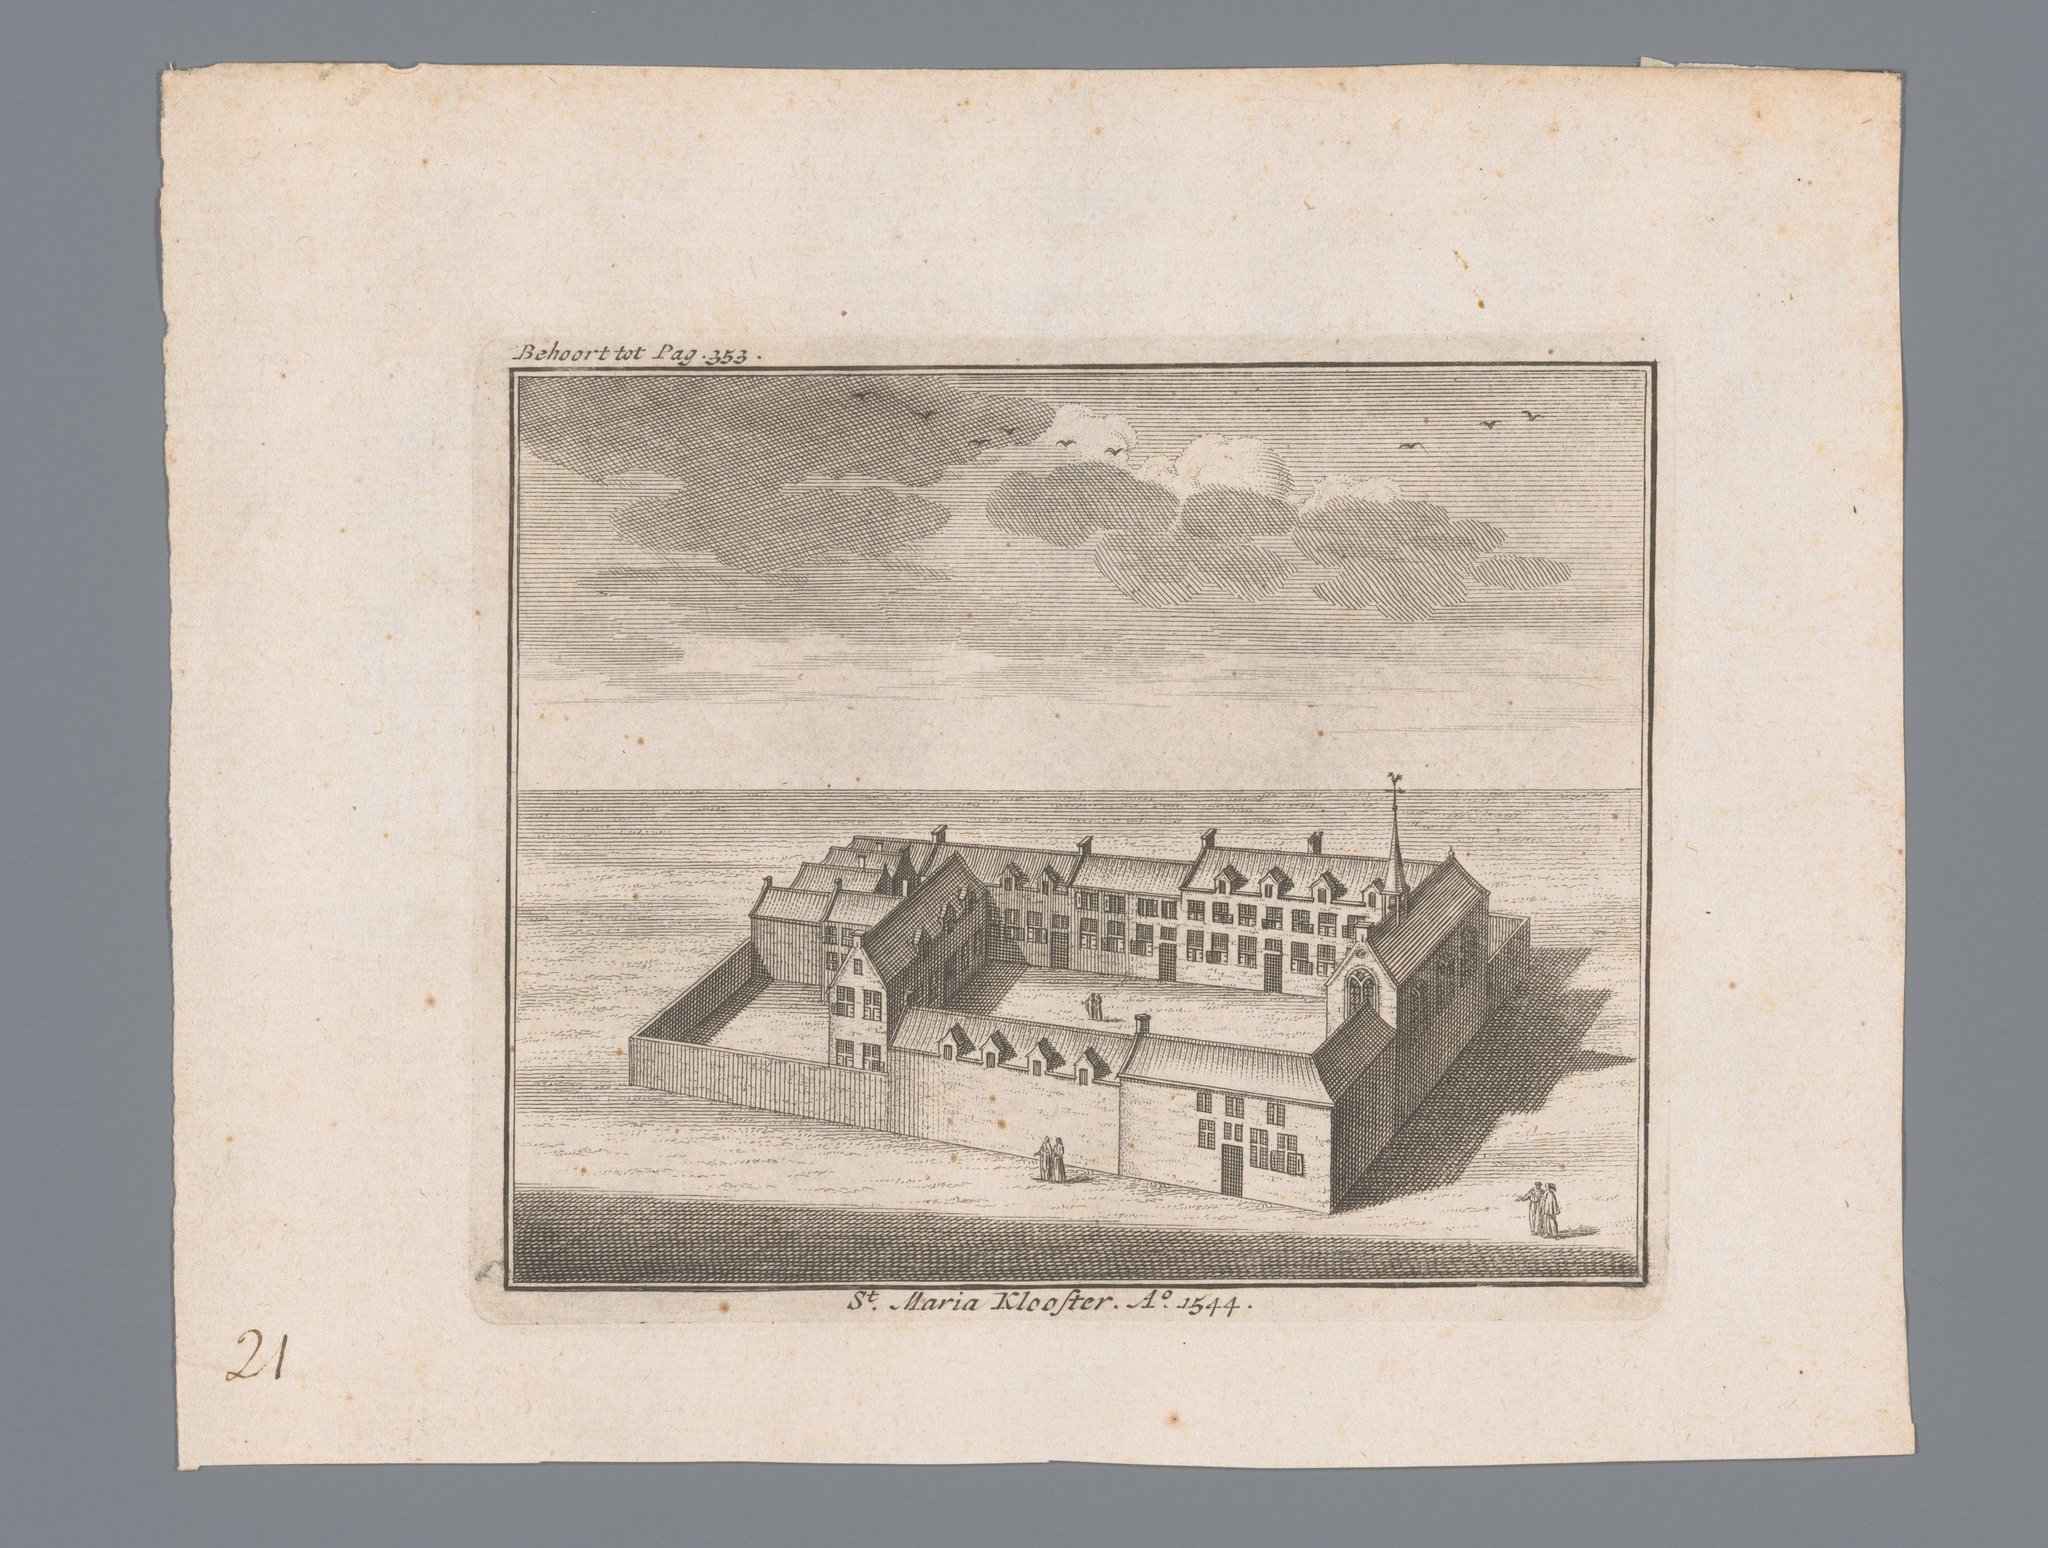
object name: print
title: St. Maria Klooster. Ao. 1544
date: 1729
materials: paper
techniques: etching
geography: amsterdam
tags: abbey, monastery, convent ~ roman catholic church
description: Prent verschenen in: Long, Isaak Le. Historische beschryvinge van de Reformatie der stadt Amsterdam. Amsterdam: Johannes van Septeren, 1729.